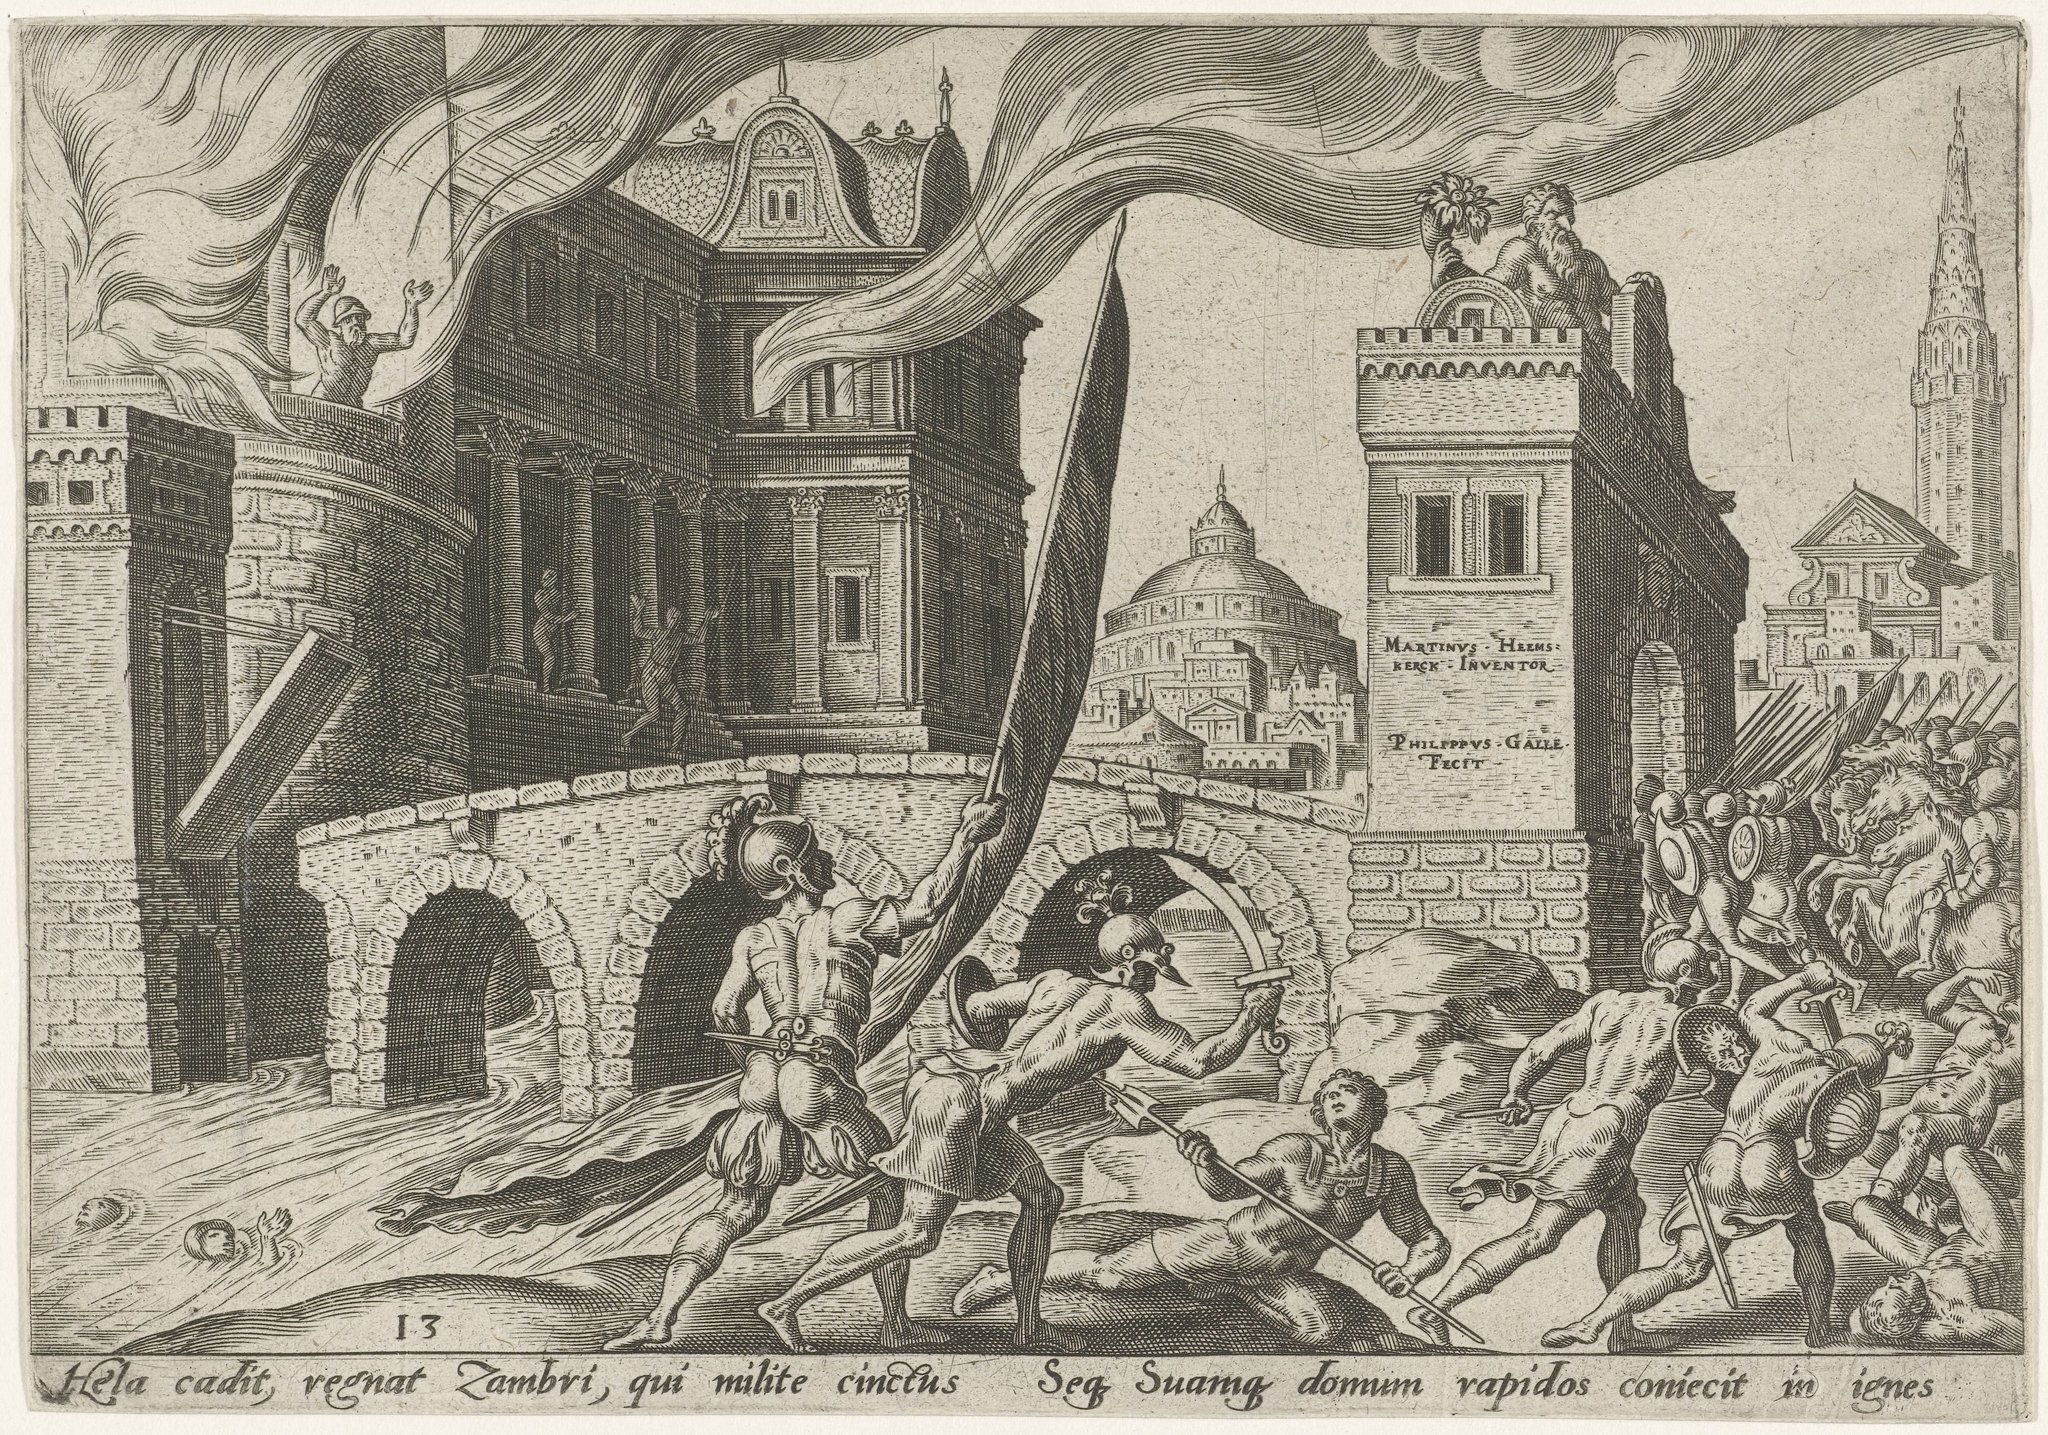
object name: print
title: De onheilsdagen van het Joodse volk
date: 1569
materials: paper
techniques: engraving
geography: haarlem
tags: omri, elah's army commander, attacks zimri in the city of tirzah; when zimri sees that the city has fallen he sets the palace on fire and dies in the flames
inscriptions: signature: ‘Martinus Heems: / kerck. Inventor’, signature: ‘Philippus. Galle./ Fecit’, caption: ‘Hela cadit, regnat Zamri, qui milite cinctus...coniecit in ignes.’, number: ‘13’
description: Omri, de aanvoerder van het leger van Ela, valt Zimri aan in de stad Tirza. Als Zimri ziet dat de stad is gevallen steekt hij het paleis in brand en gaat hij ten onder in de vlammen. Op de voorgrond rechts het leger van Omri, dat door de stadpoort naar binnen trekt. Linksachter Zimri op het bordes van het brandende paleis.